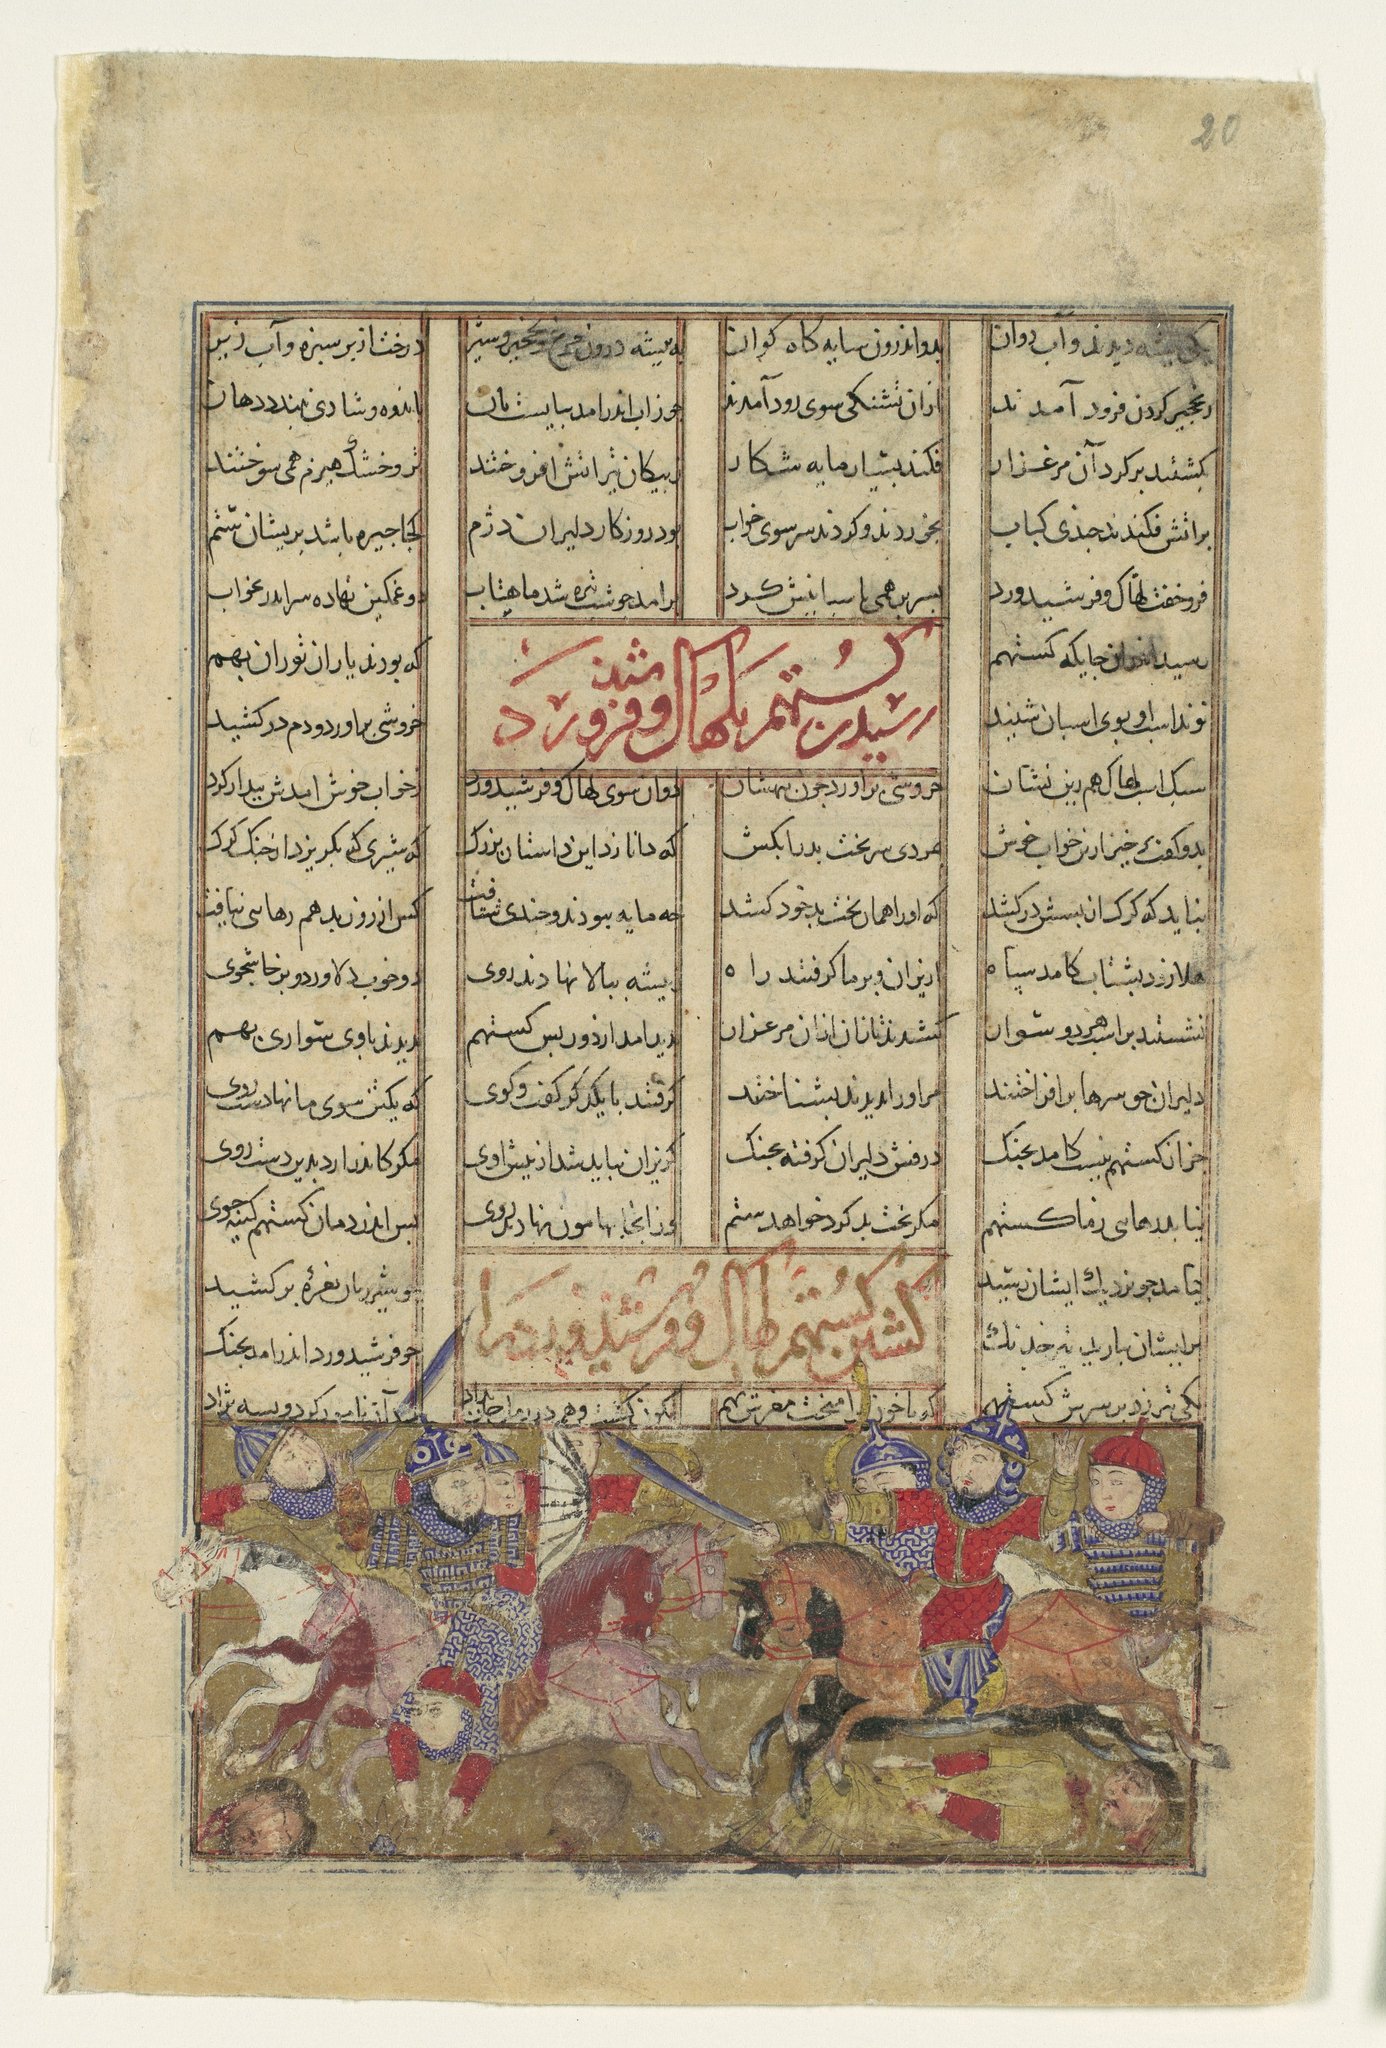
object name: folio from an illustrated manuscript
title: "Gustaham Slays Lahhak and Farshidvard", Folio from a Shahnama (Book of Kings)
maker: abu'l qasim firdausi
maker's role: author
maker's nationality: iranian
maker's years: 935-1020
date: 1330-1340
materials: gold, ink, paper, silver, watercolor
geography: iran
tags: battles,men,horses